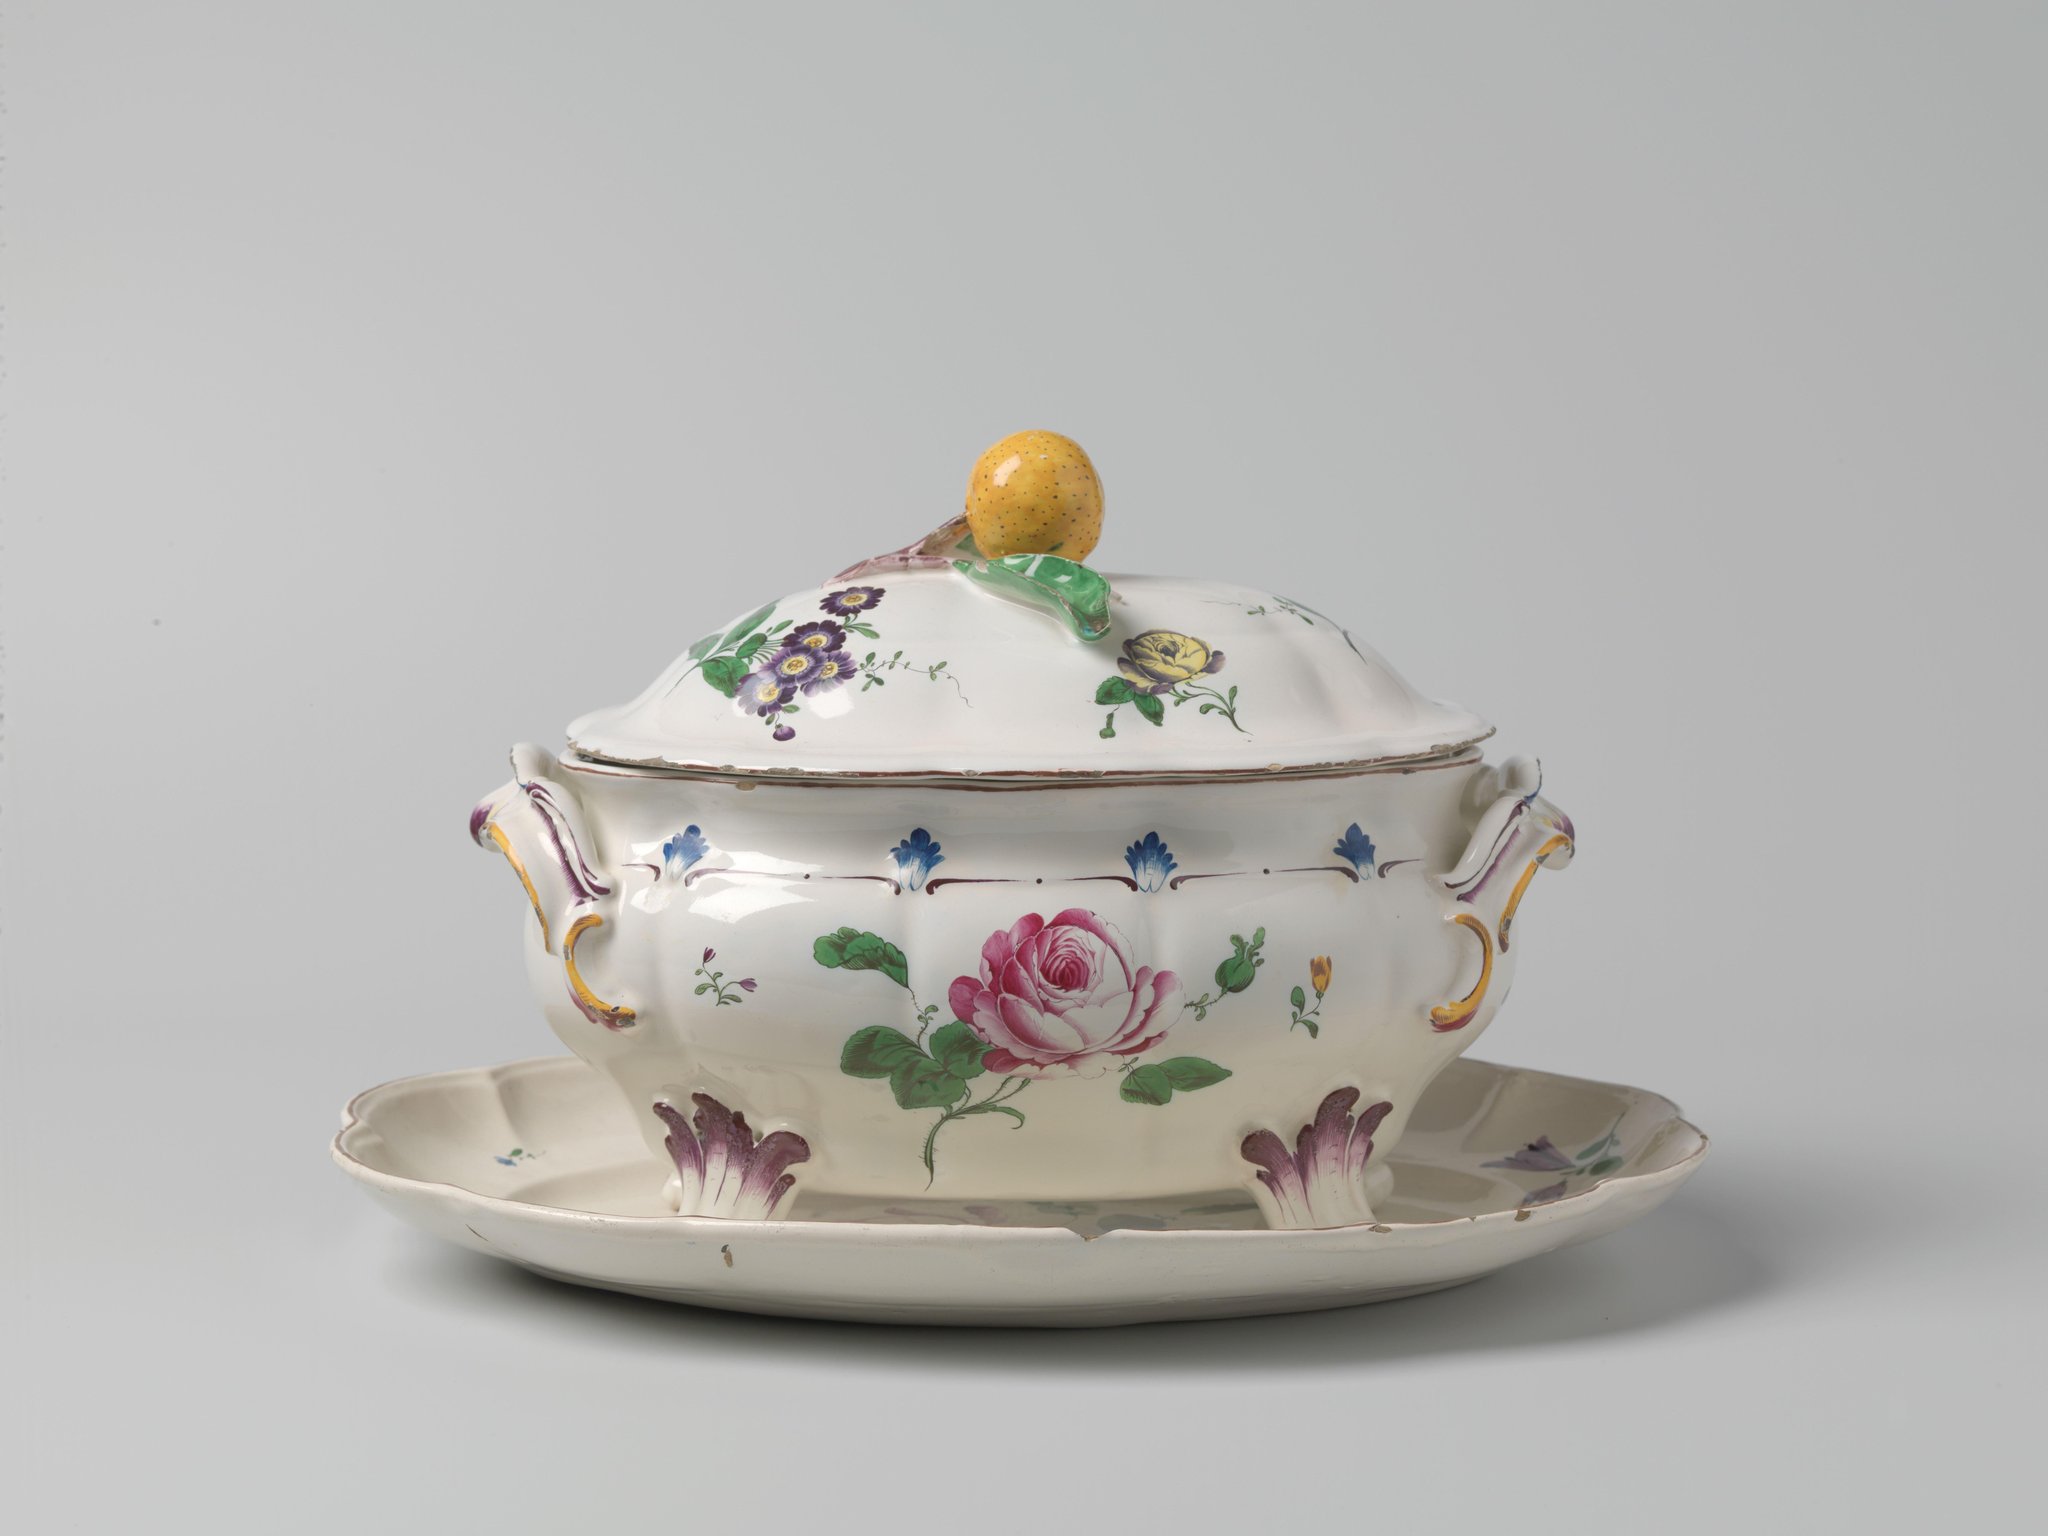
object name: tureen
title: Terrine, beschilderd met strooimotief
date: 1760-1770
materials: faience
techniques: painted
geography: ludwigsburg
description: Terrine, staand op vier pootjes, veelkleurig versierd met losse bloemtakjes. Gemerkt in blauw met dubbele C .Z.